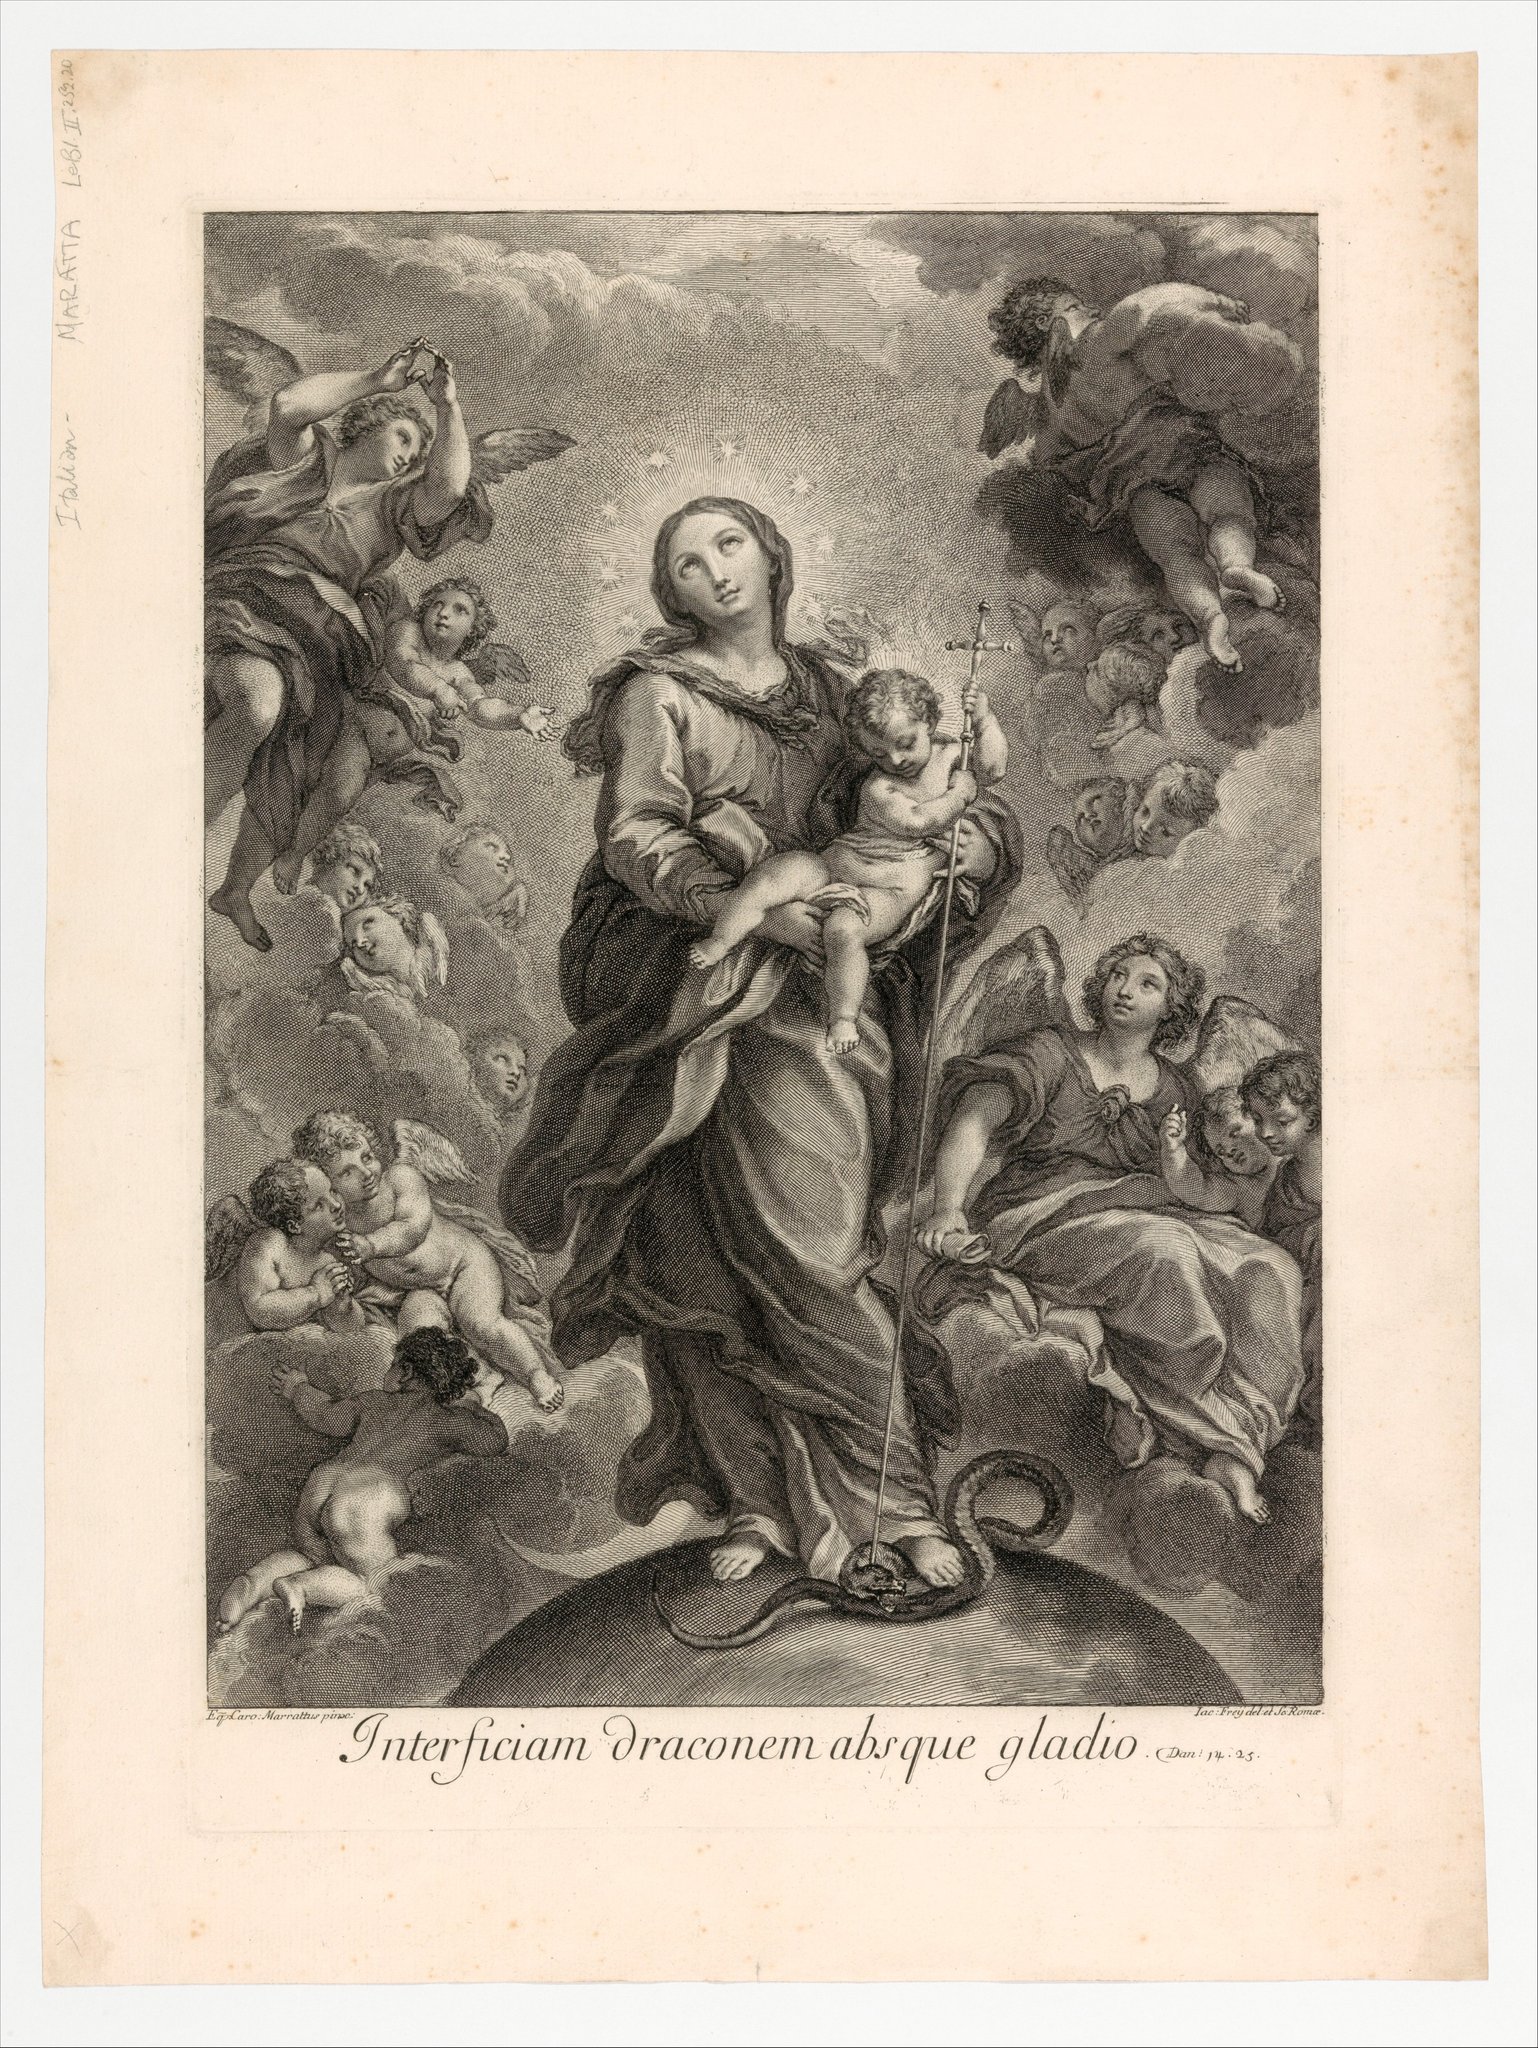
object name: print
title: Destroy the dragon without sword; (Dan. 14.25); Virgin and Child on hemisphere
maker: johann jakob frey the elder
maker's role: artist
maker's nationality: swiss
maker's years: 1681-1752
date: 1681-1752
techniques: engraving, etching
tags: dragons,angels,madonna and child,cross